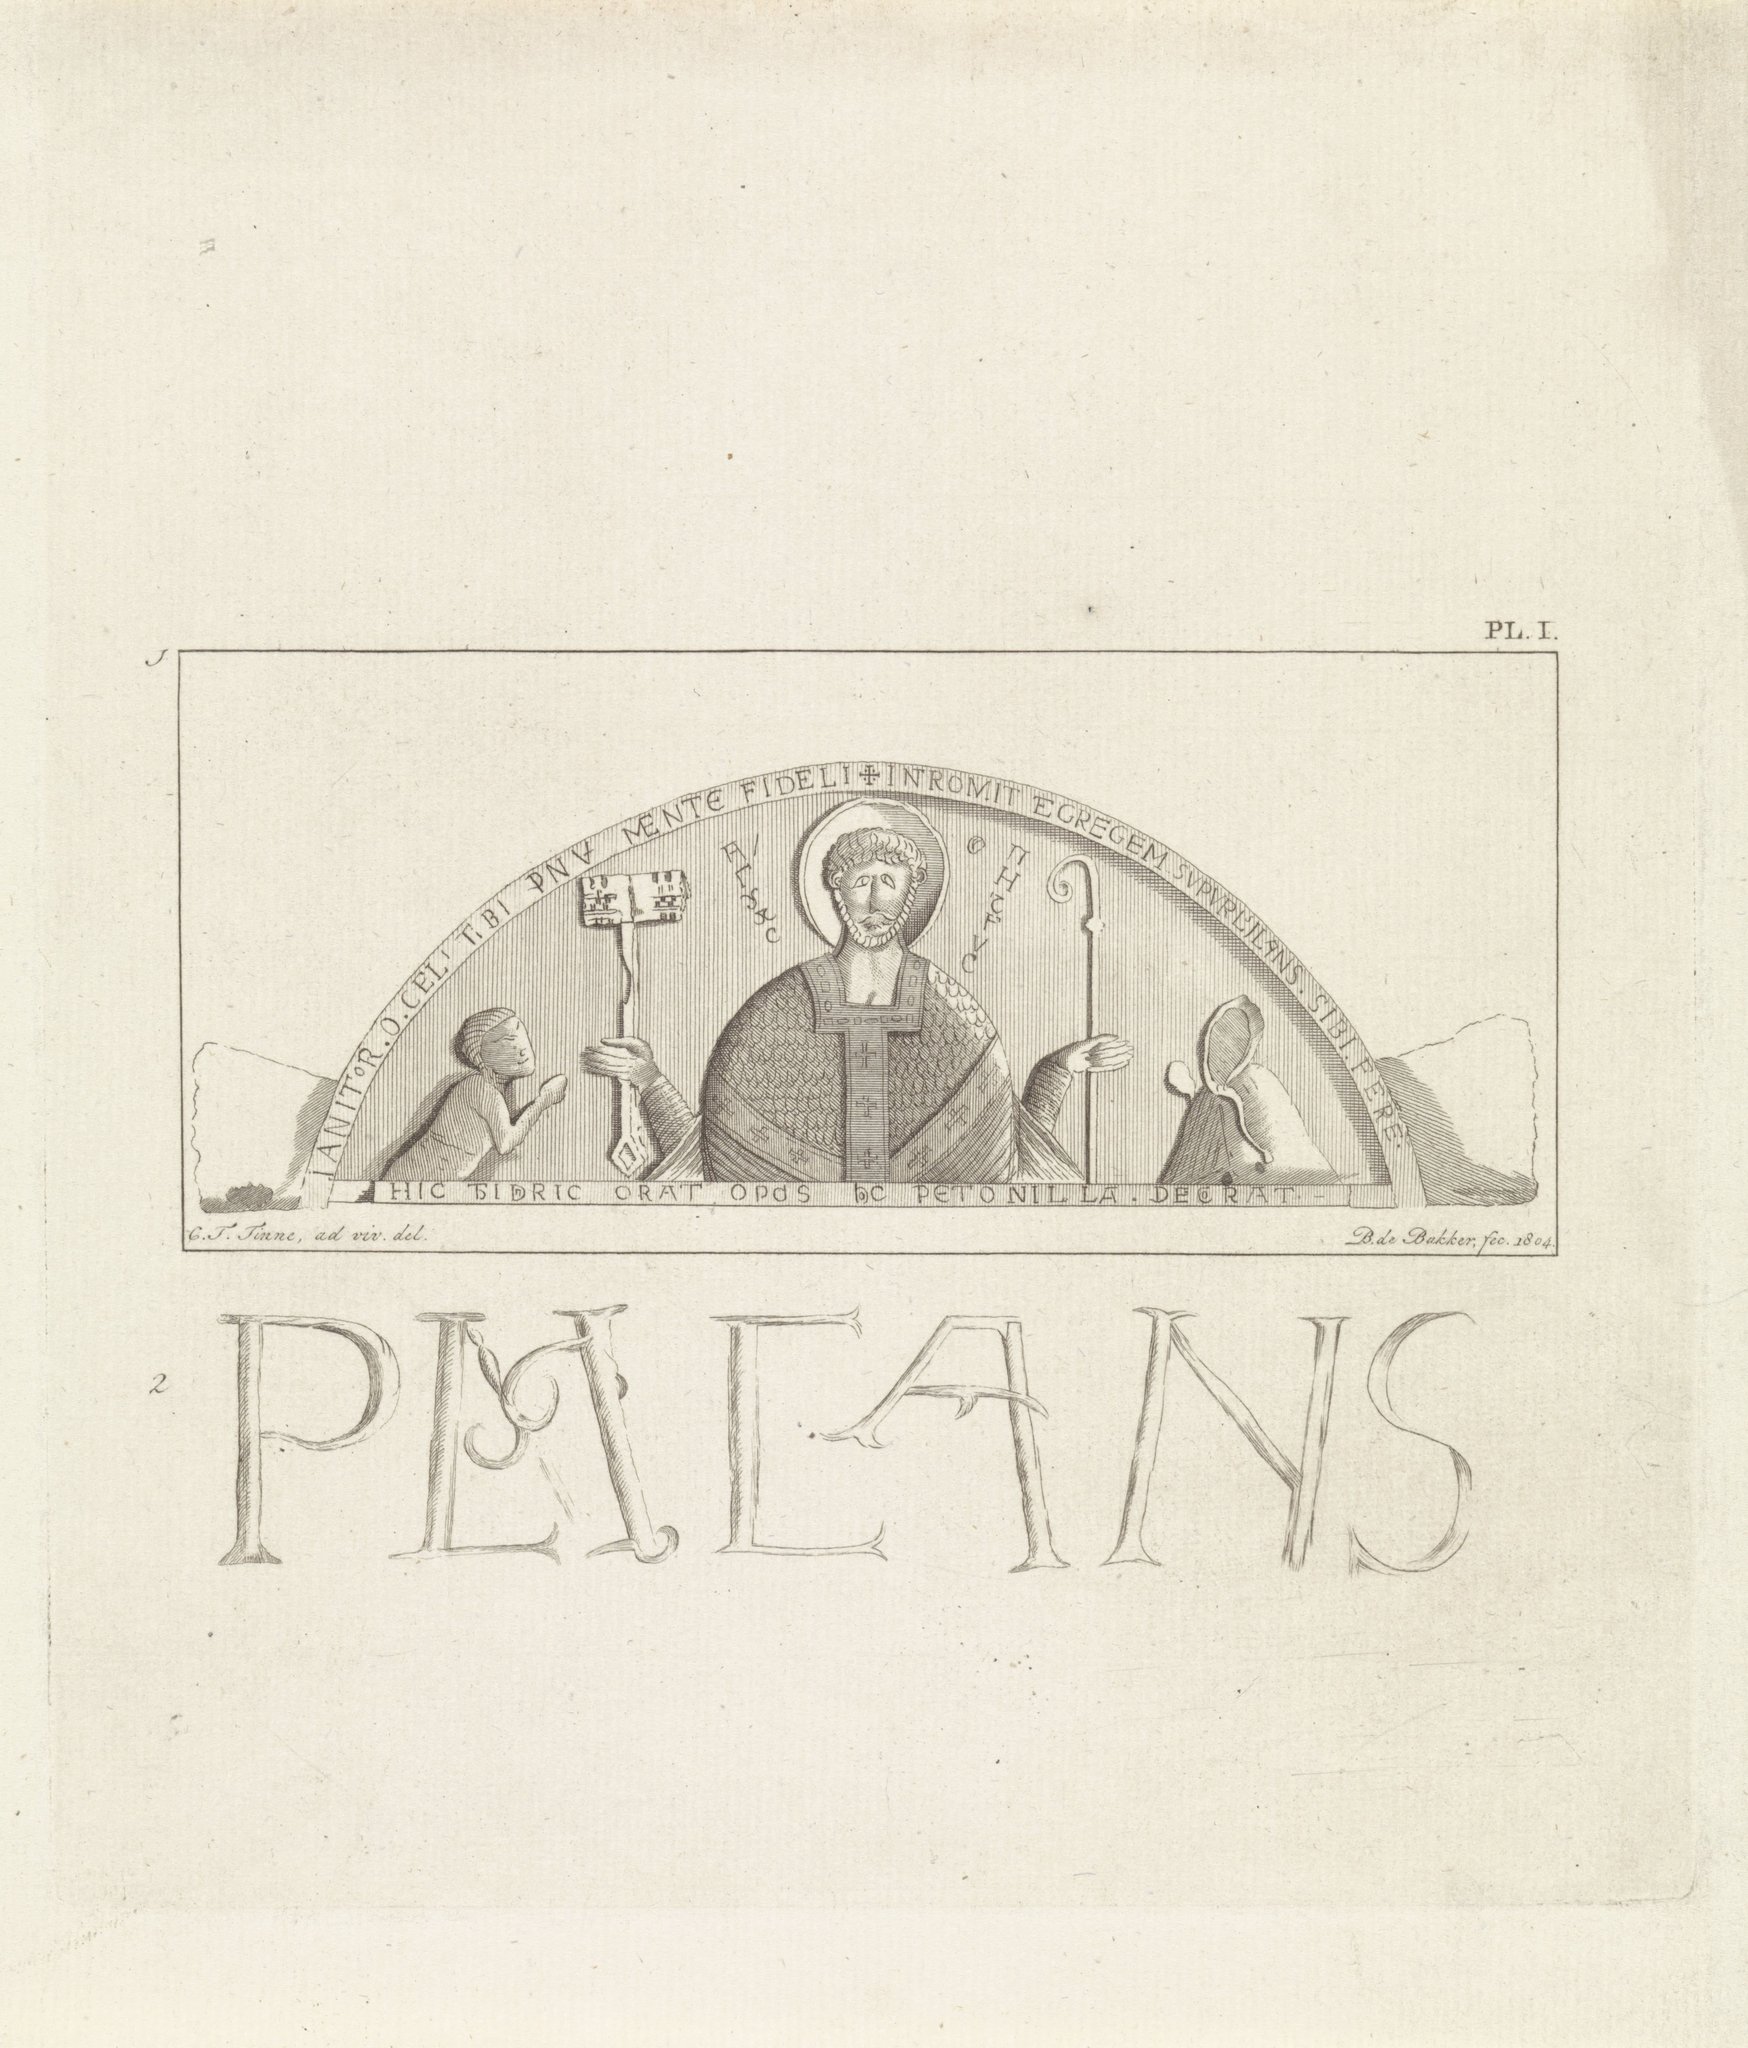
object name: print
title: Reliëf op het timpaan van Egmond met heilige Petrus en graaf Dirk VI van Holland en gravin Petronella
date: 1804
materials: paper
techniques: etching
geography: amsterdam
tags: the apostle peter, first bishop of rome; possible attributes: book, cock, (upturned) cross, (triple) crozier, fish, key, scroll, ship, tiara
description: Prent naar Chrétien Théodore Tinne. Tinne baseerde zich op een anonieme sculptuur welke zich tegenwoordig bevindt in de collectie van het RMA (vergelijk BK-NM-1914). Prent gebruikt voor onbekende uitgave, pl. 1).